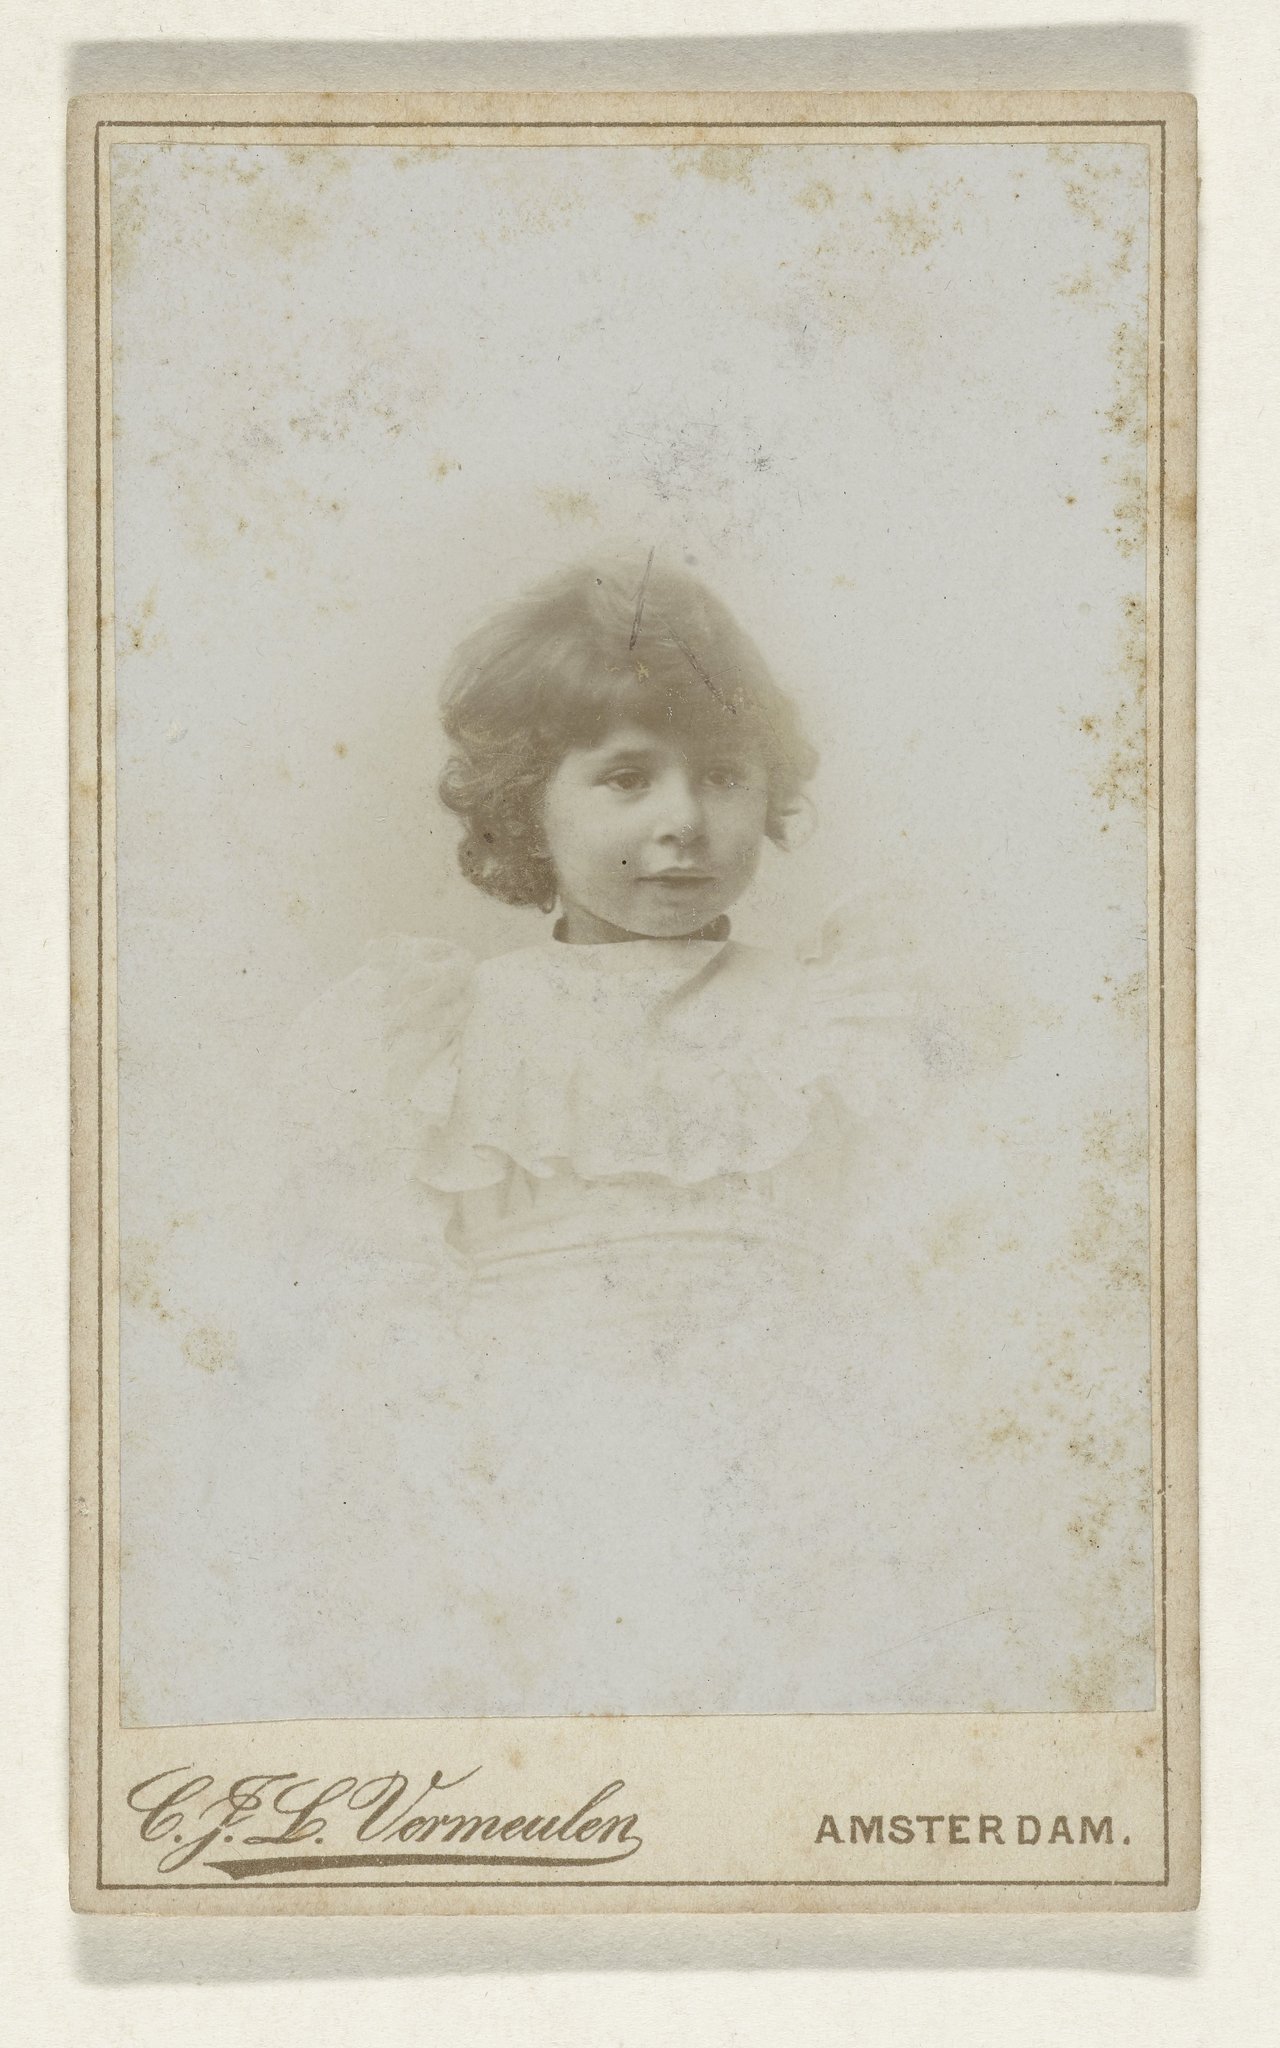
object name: carte de visite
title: Studioportret van een jong meisje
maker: cornelis johannes lodewicus vermeulen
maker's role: fotograaf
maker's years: 1861-1936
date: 1890-1915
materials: paper, photographic support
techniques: photography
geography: amsterdam